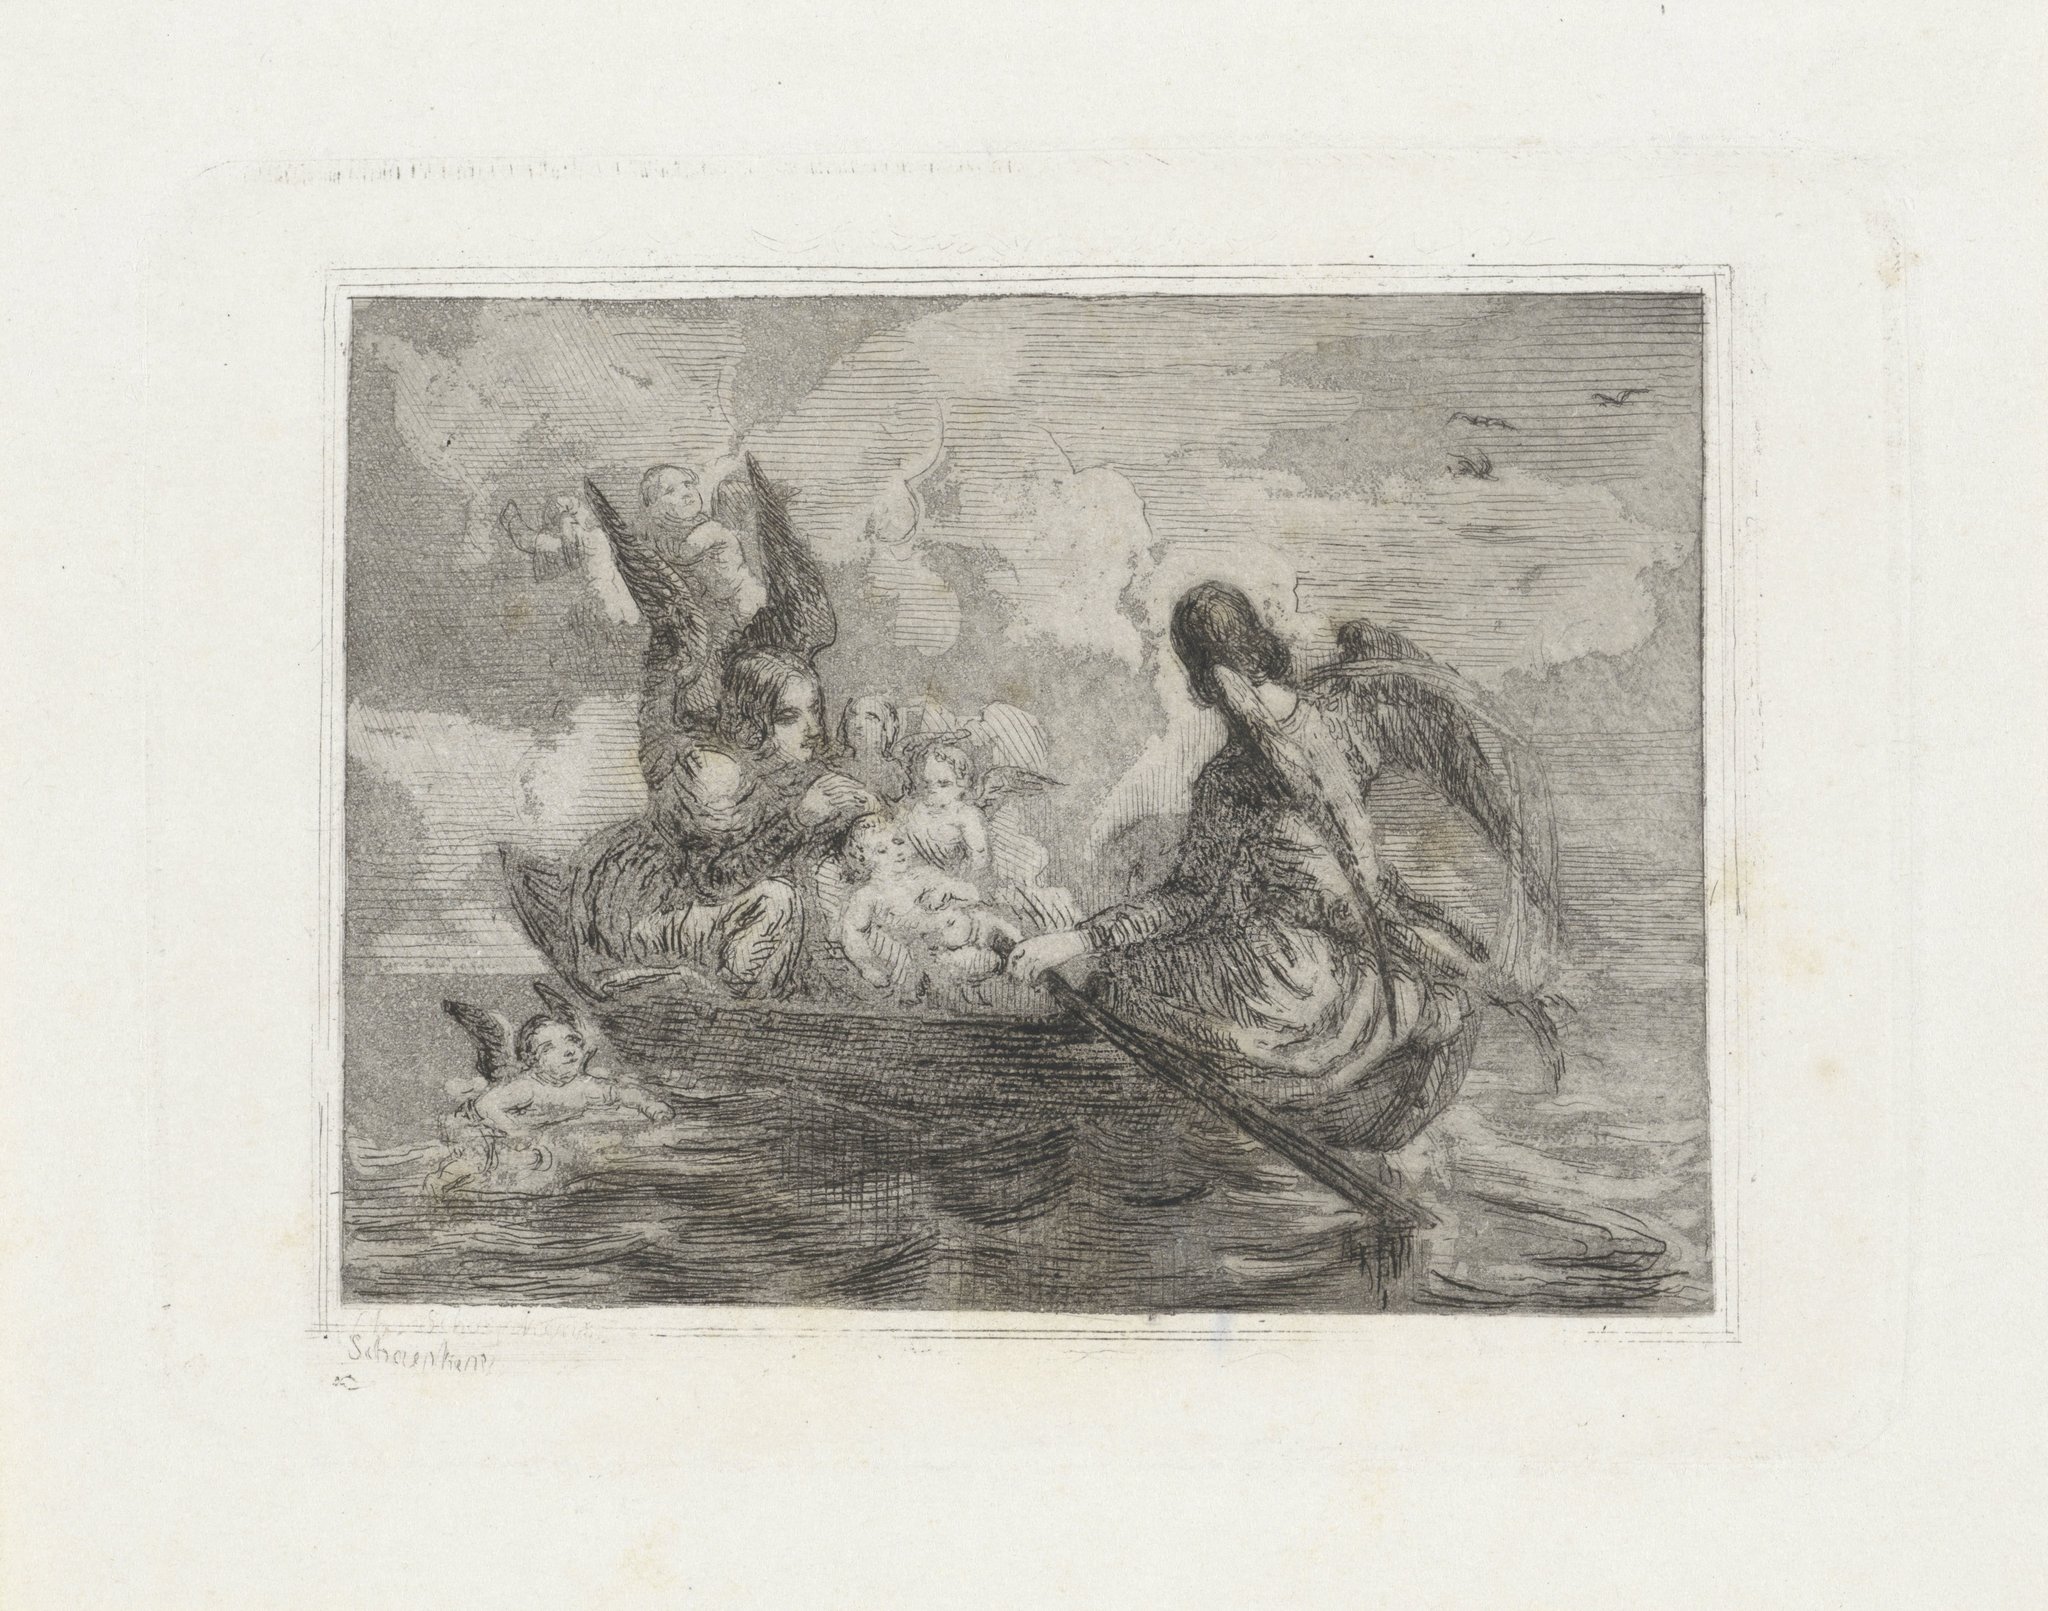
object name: print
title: Varende engelen met het Christuskind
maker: theodoor schaepkens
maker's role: draughtsman, print maker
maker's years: 1810-1883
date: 1825-1883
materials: paper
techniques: aquatint, drypoint, etching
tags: rowing-boat, canoe, etc., christ-child together with others, angels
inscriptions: collector's mark: Lugt 2228